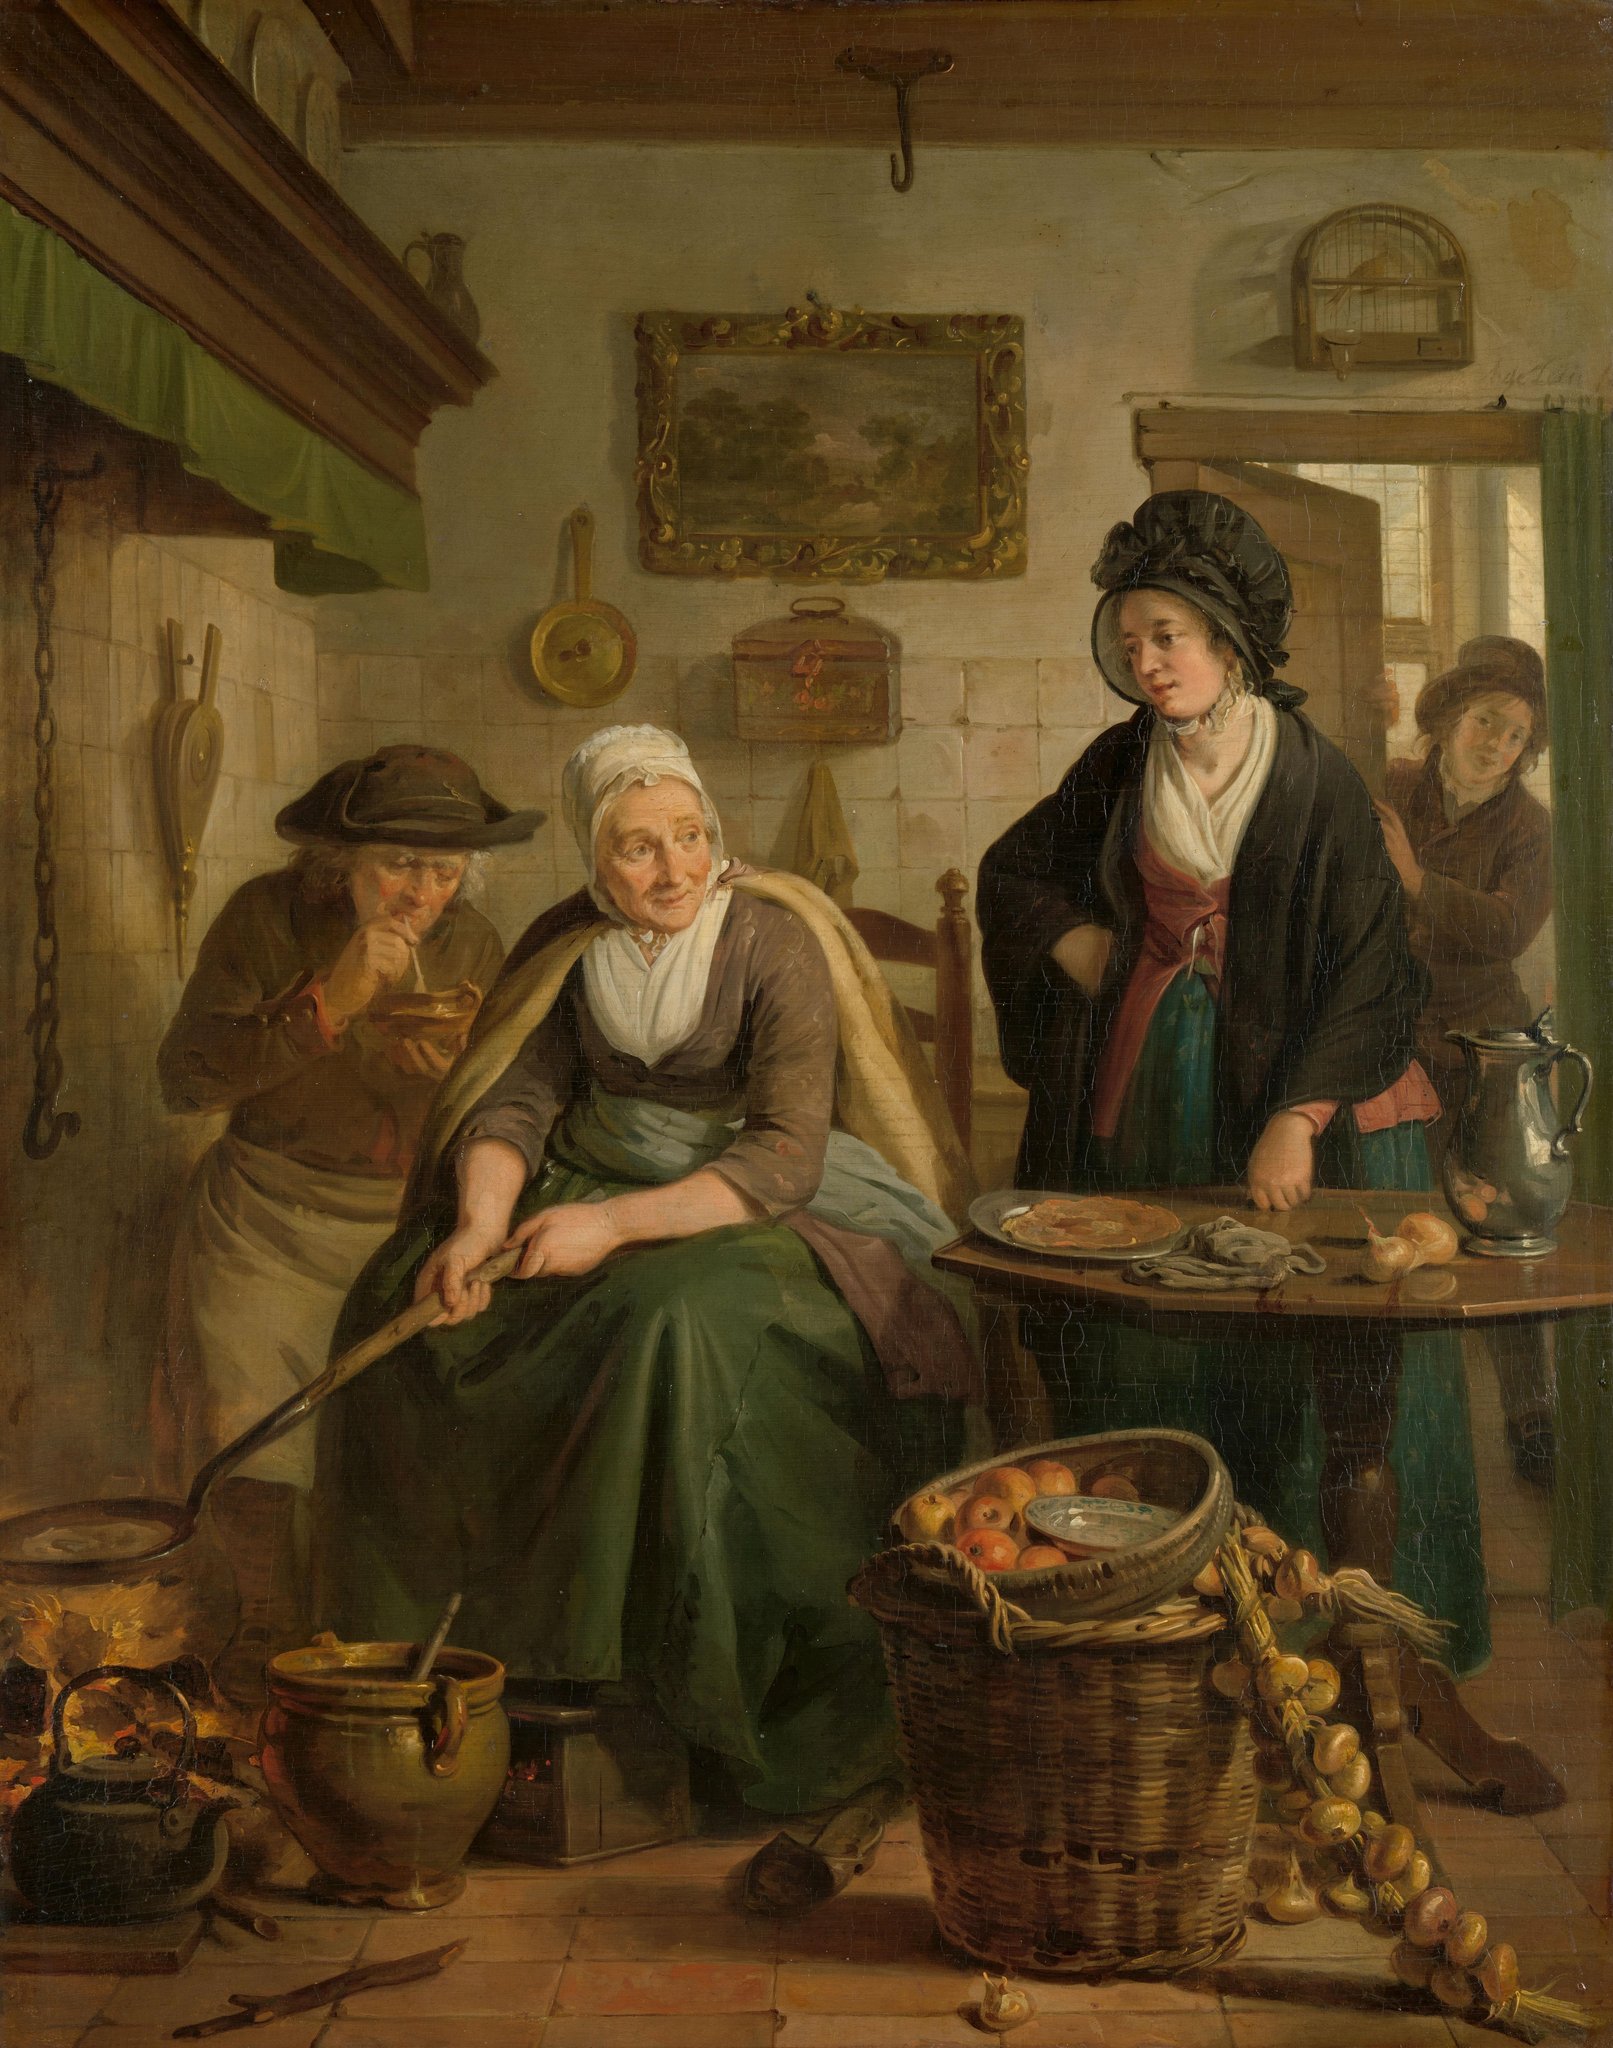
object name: painting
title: Old Woman making Pancakes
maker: adriaan de lelie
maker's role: draughtsman, painter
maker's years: 1755-1820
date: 1790-1810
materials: oil, panel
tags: kitchen, pancakes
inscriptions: signature: ‘A. de Lelie fec.’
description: As in the painting Morning Visit, in this kitchen, too, an old man is preparing to smoke his pipe. A young woman has just entered and a boy stands in the door opening, both perhaps enticed by the smell of pancakes. Because of the young woman’s attire, this interior makes a more contemporary impression than Morning Visit.